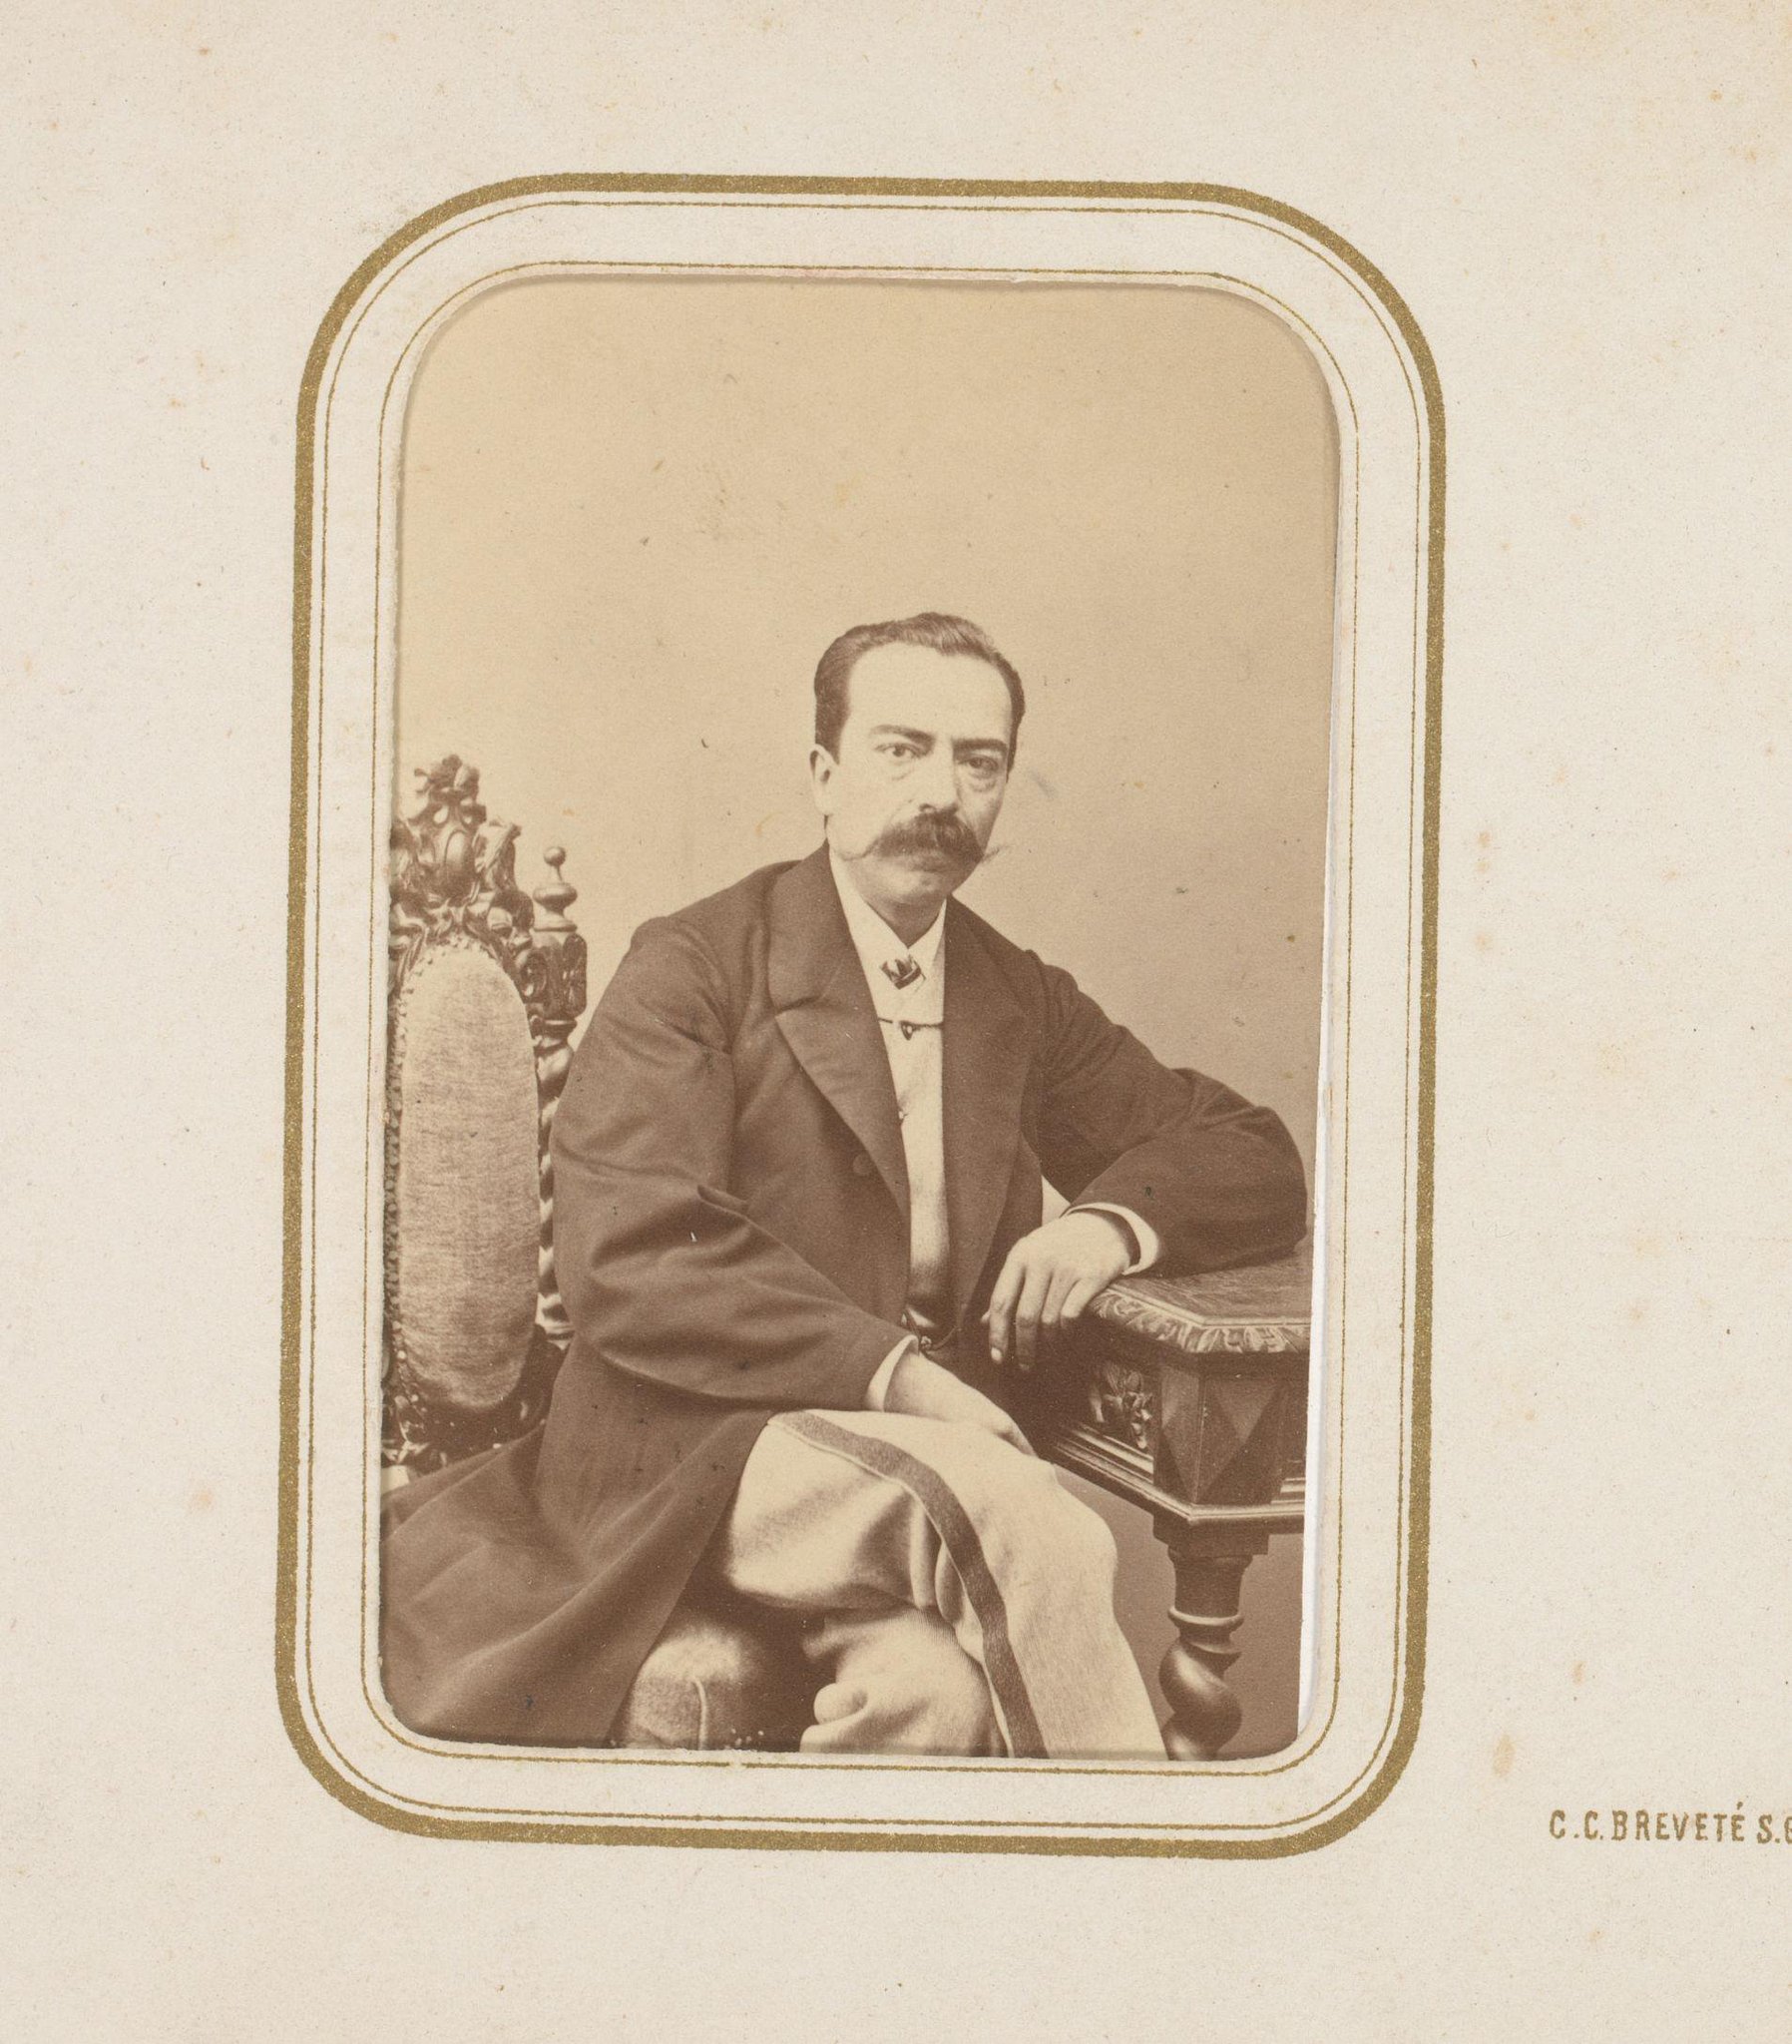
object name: photograph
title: Portret van een man met snor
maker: josé garcía ayola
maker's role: fotograaf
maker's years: 1836-1900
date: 1860-1900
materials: cardboard, photographic support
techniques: albumen print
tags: sitting figure, moustache, adult man, historical persons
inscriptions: inscription: ‘J. García Ayola/Calle de Recogidas 33./ Granada’